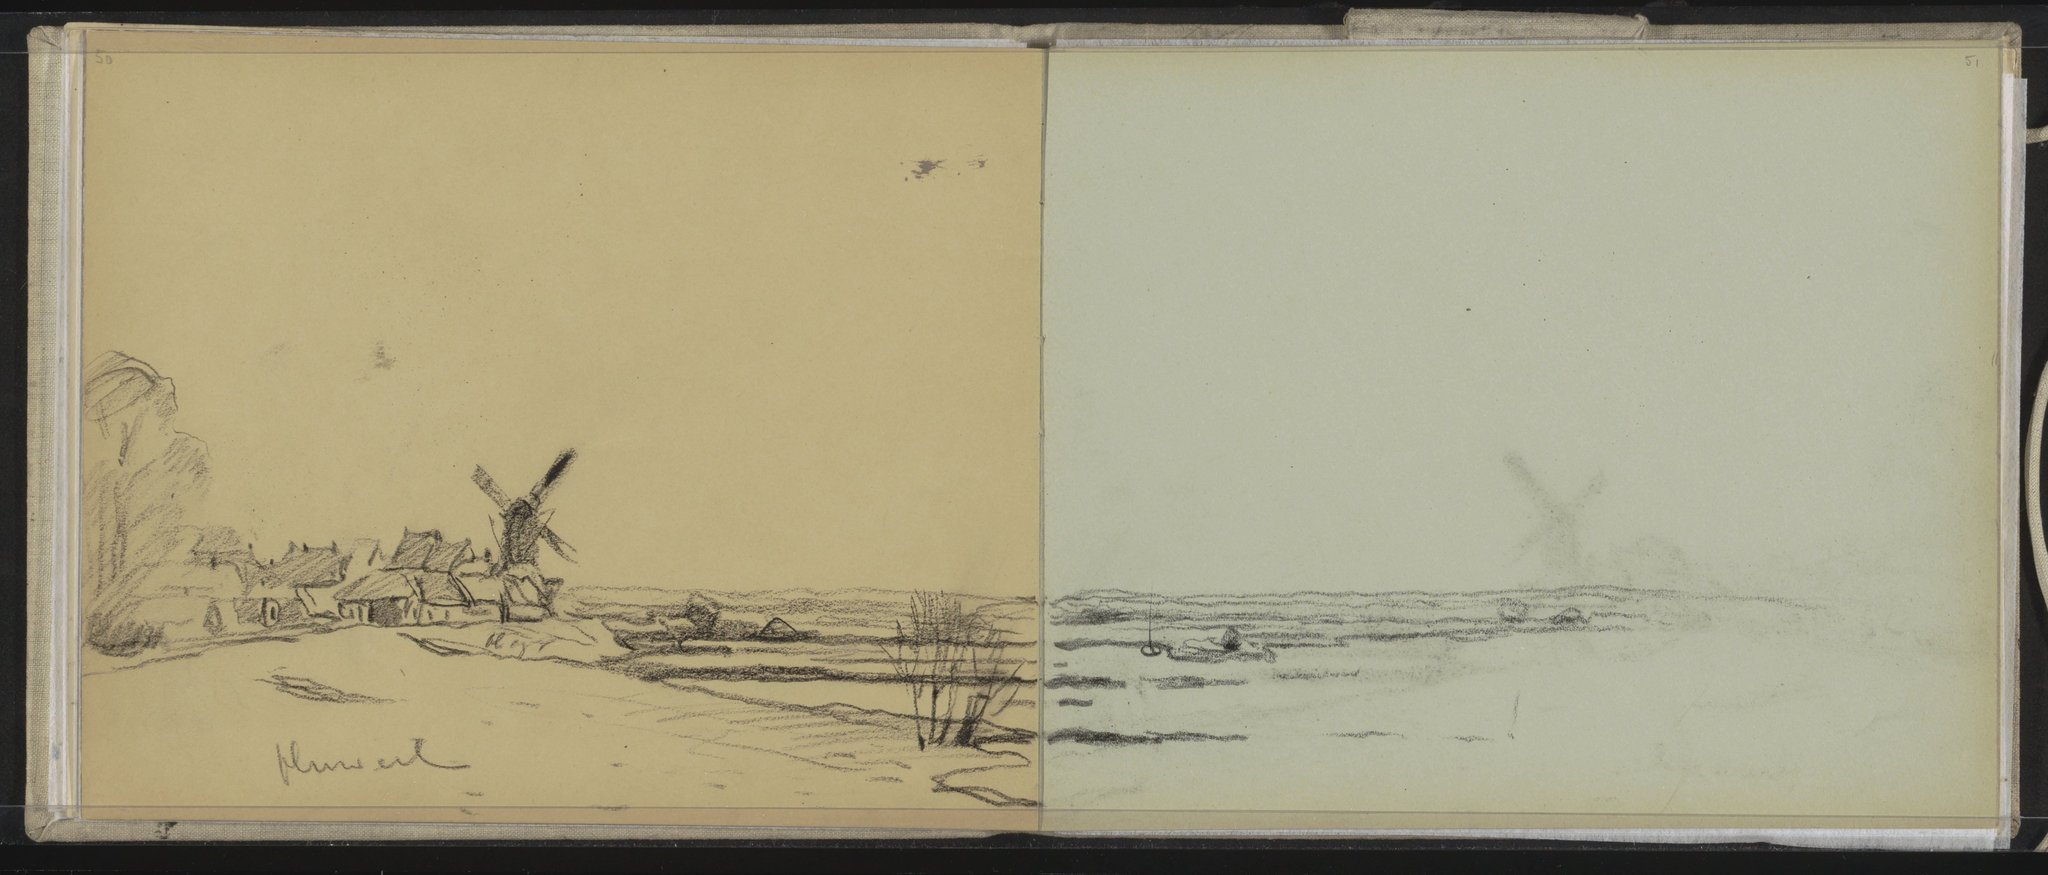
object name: sketchbook leaf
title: Gezicht op Wijk bij Duurstede met de molen Rijn en Lek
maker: willem witsen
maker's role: draughtsman, painter, print maker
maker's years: 1860-1923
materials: chalk, paper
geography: wijk bij duurstede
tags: city-view, and landscape with man-made constructions, river, windmill in landscape, lower rhine region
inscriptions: : ‘fluweel’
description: Rechts de Nederrijn en de Kromme Rijn. Pagina 50 en pagina 51 uit een schetsboek met 43 bladen.